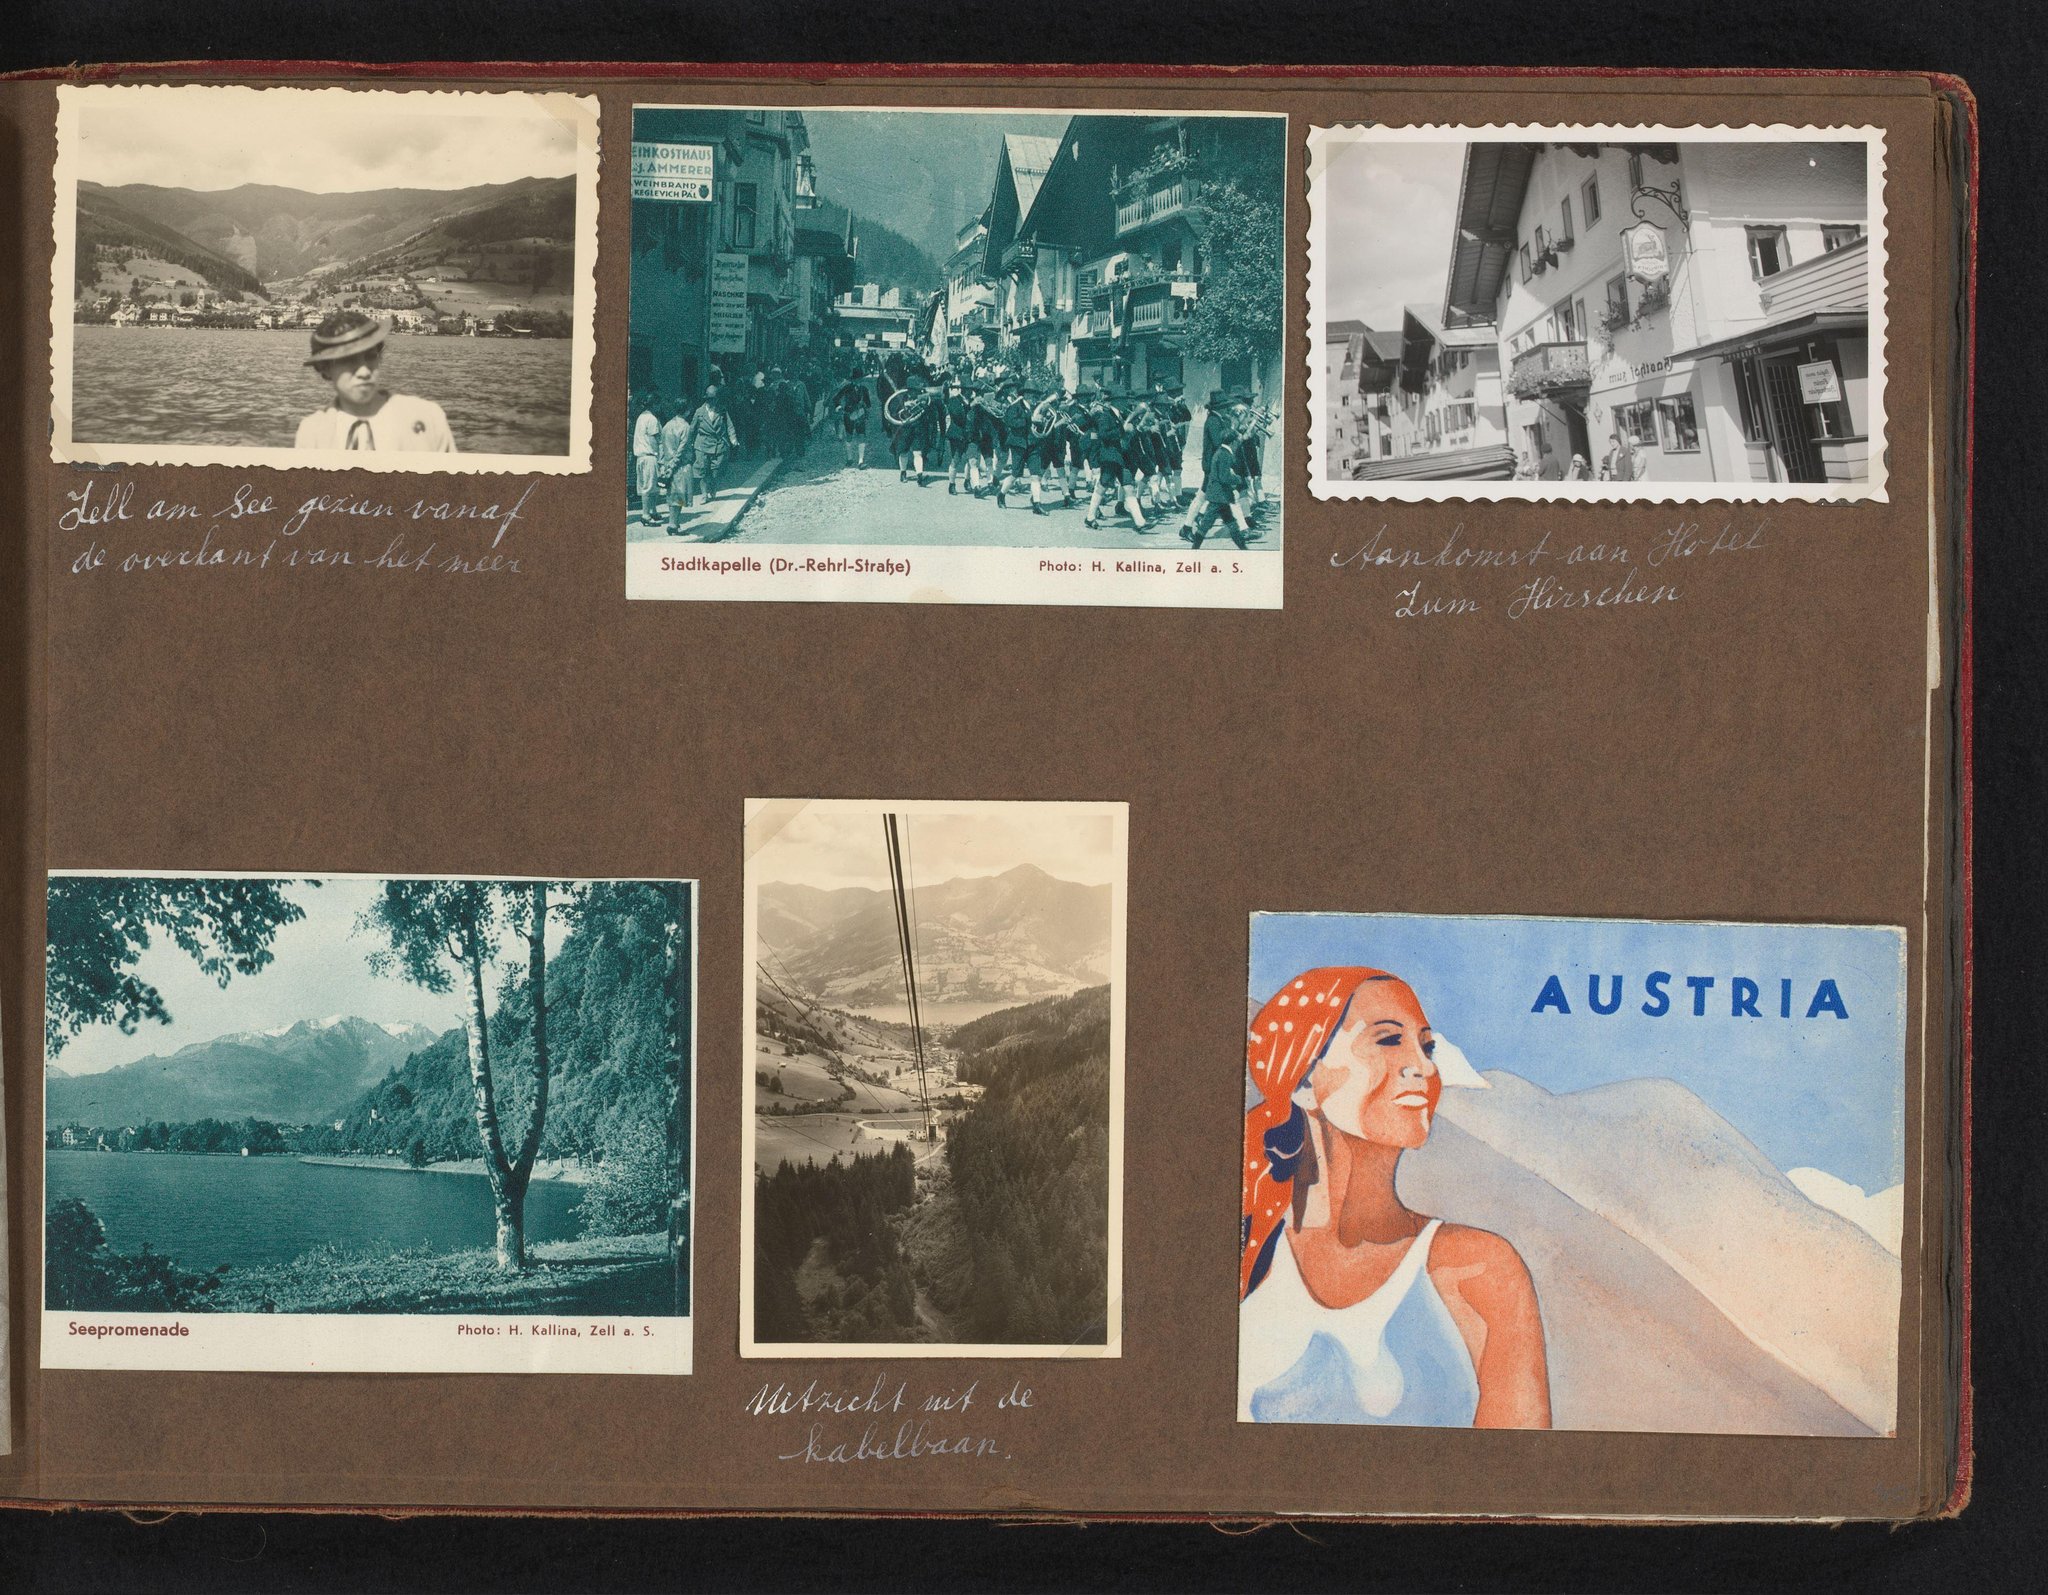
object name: photomechanical print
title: Zell am See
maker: Anonymous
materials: paper, photographic support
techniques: gelatin silver print, rotogravure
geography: austria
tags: outing, pleasure trip, mountains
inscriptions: inscription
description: Albumblad met drie foto's en drie afbeeldingen van Zell am See en omgeving. Verslag van een twaalfdaagse groepsreis per autobus naar Salzburgerland en Beieren van 30 juli tot 10 augustus 1936. Onderdeel van het reisalbum van de familie Van den Broek 1935-1937.